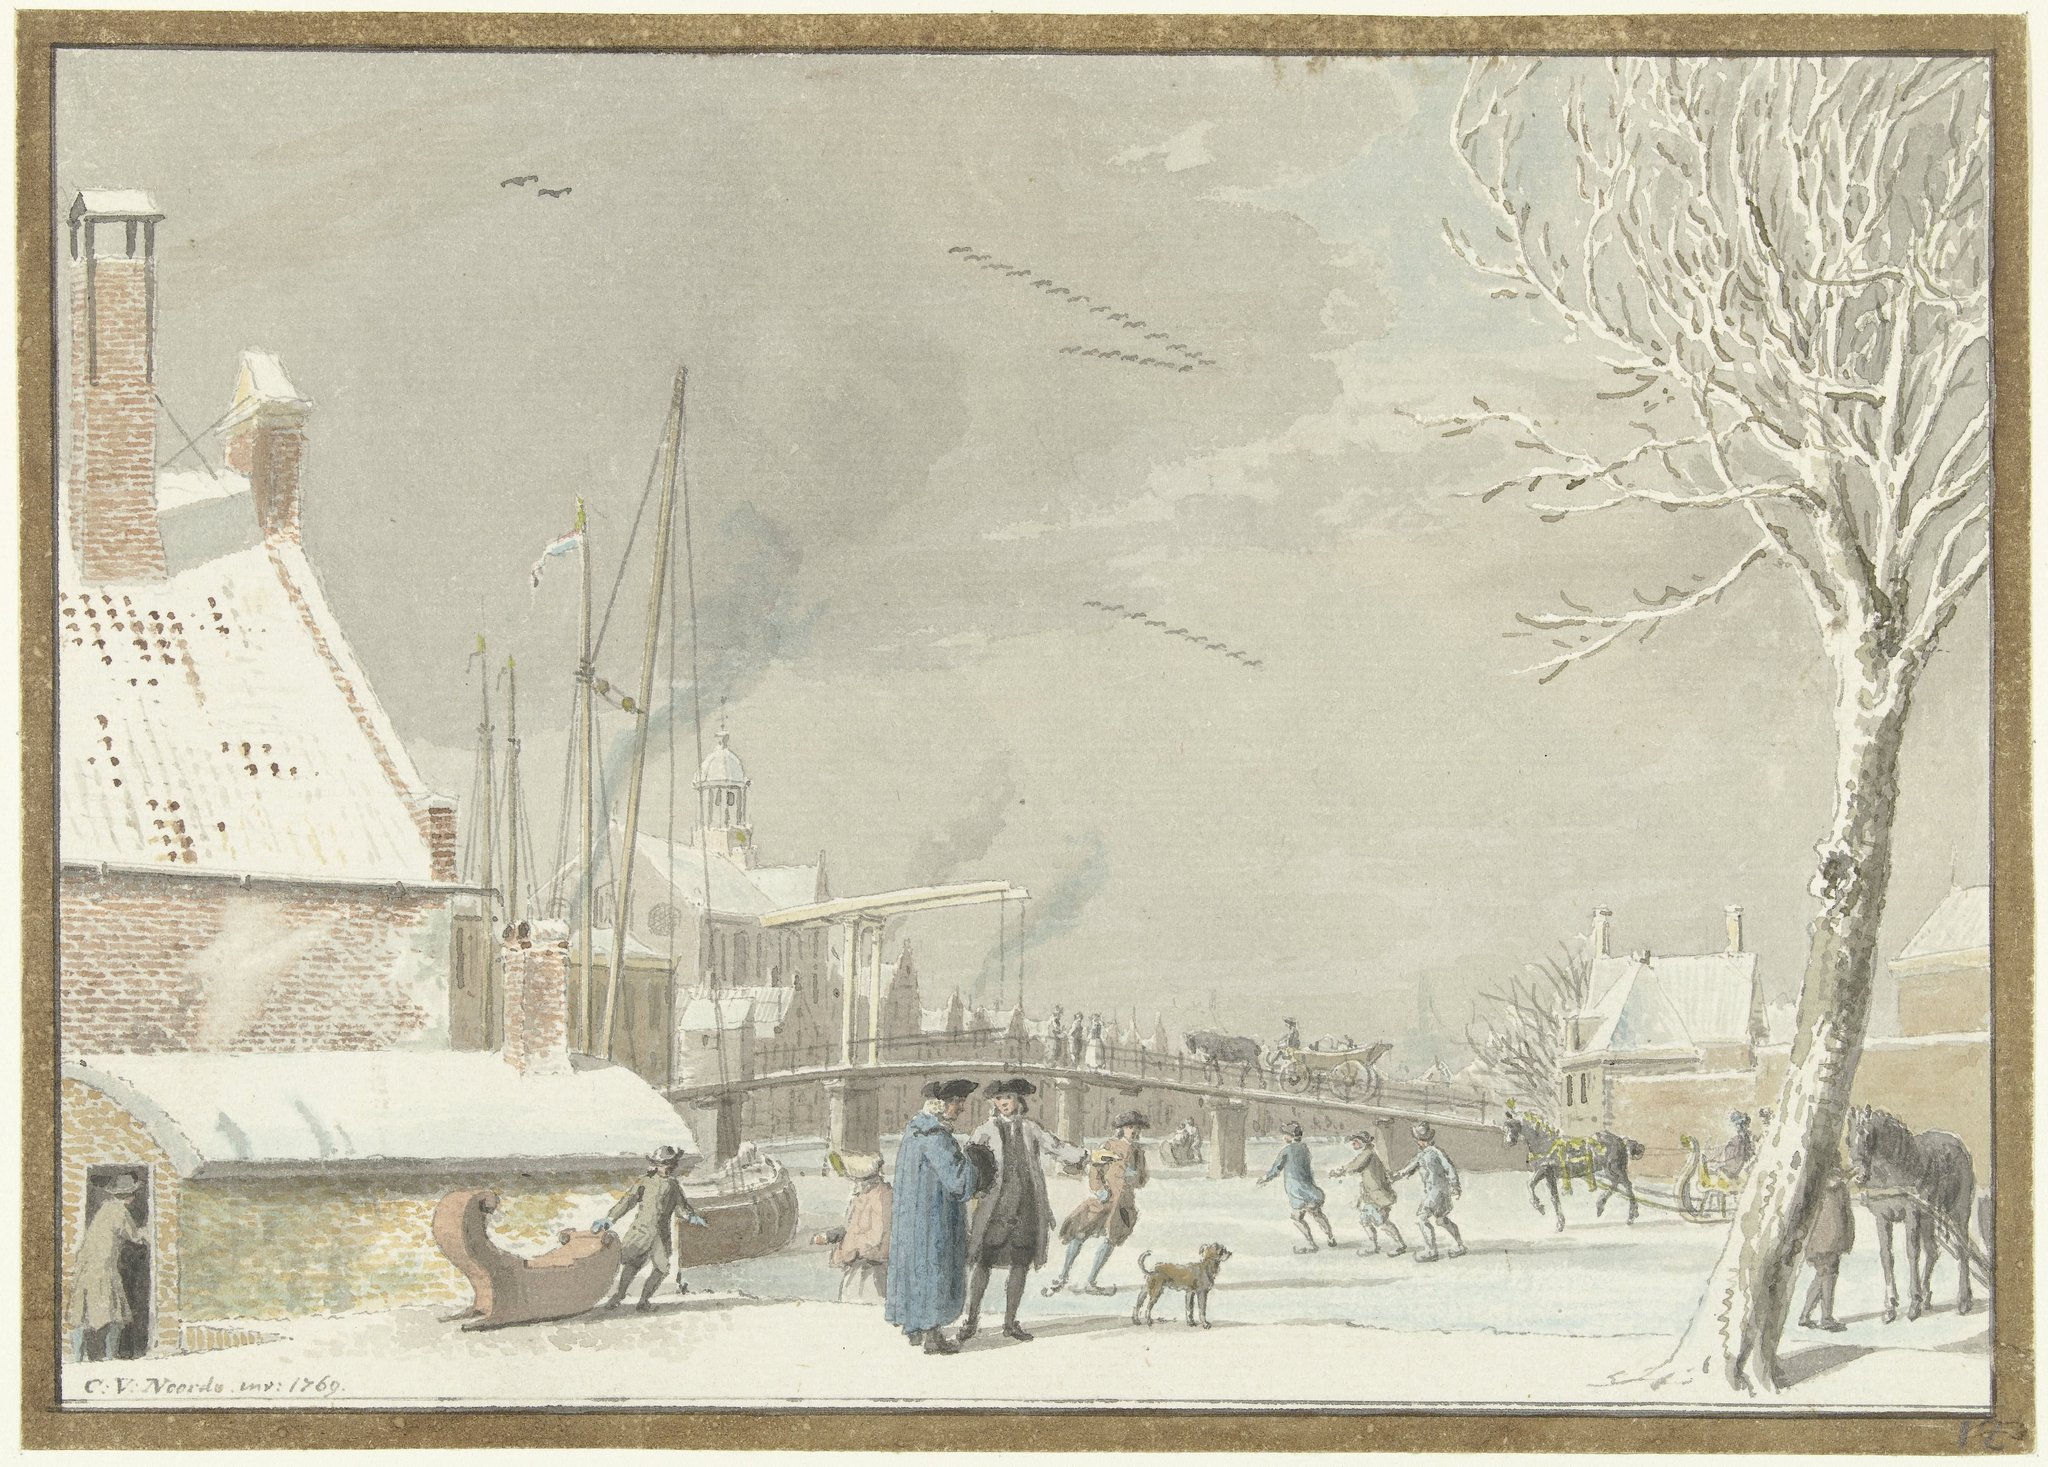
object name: drawing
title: Bevroren stadsgracht met schaatsers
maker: cornelis van noorde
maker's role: draughtsman, print maker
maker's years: 1731-1795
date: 1769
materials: ink, paper, watercolor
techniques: brush, pen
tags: winter sports, ice ~ freezing weather, canals, waters (in city)